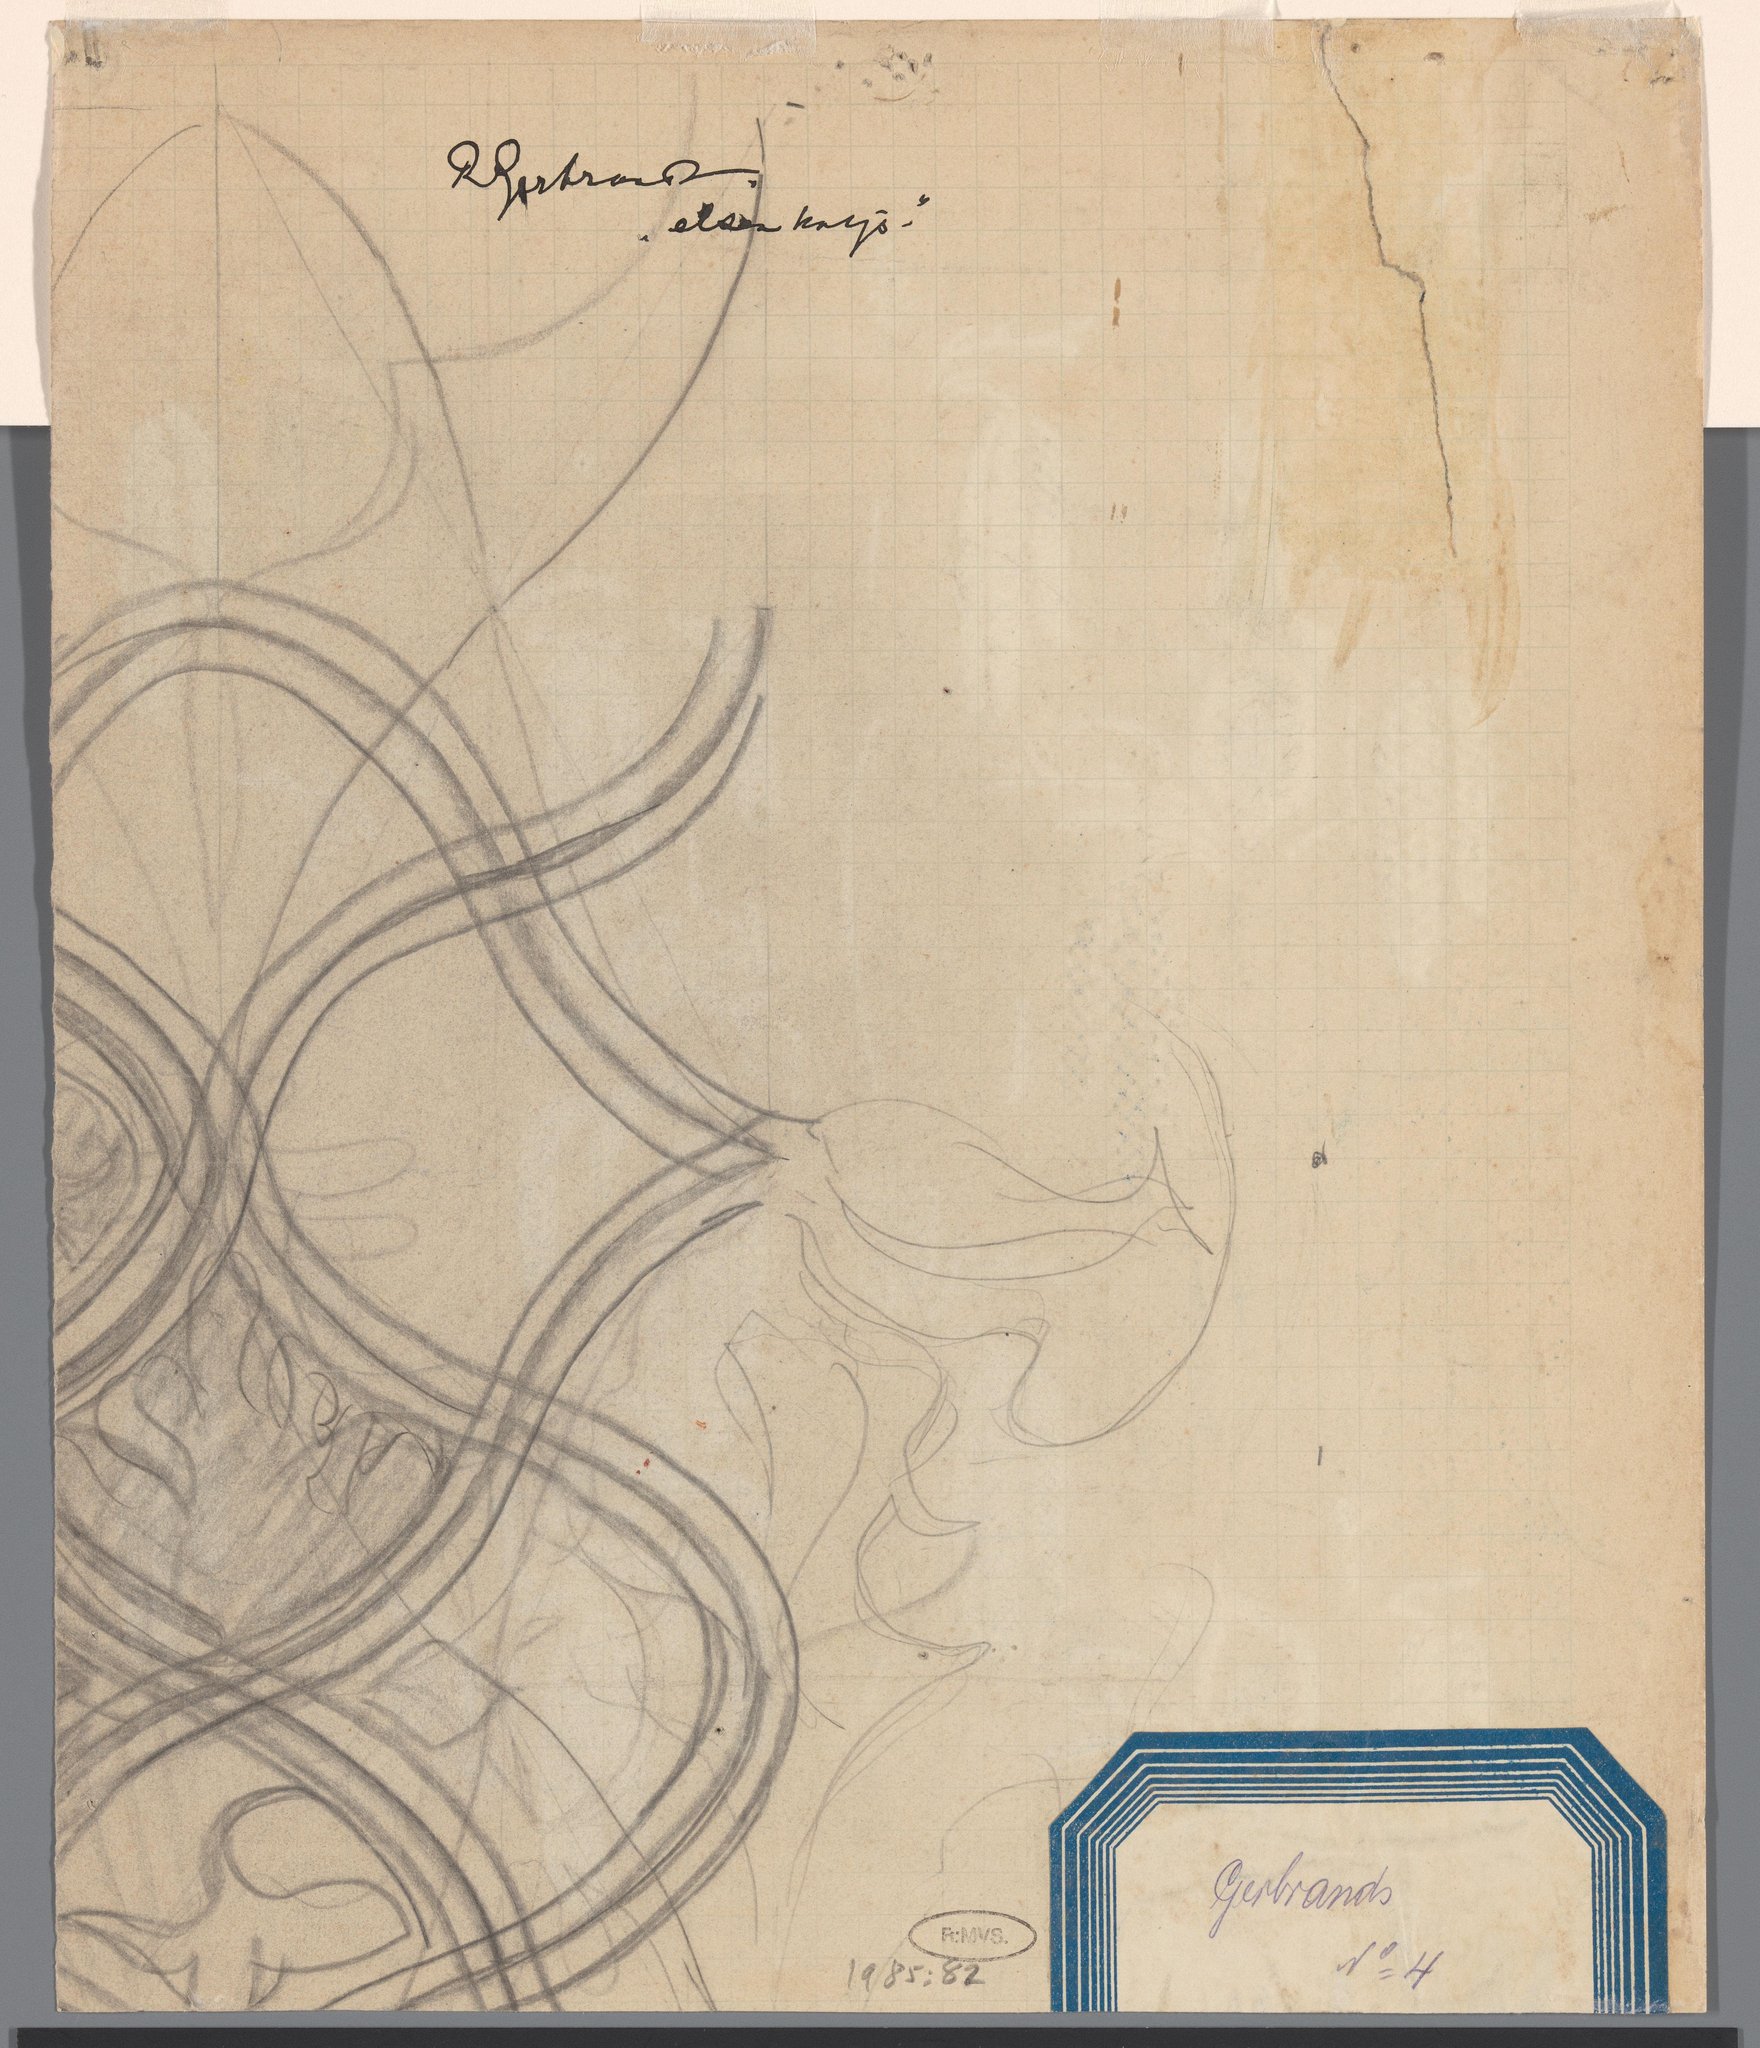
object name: drawing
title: Decorative Designs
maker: roelf gerbrands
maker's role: designer, draughtsman, print maker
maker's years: 1891-1954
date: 1921-1954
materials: pencil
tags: ornament derived from plant forms - aa - stylized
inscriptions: : ‘Gerbrands No = 4’, collector's mark: Lugt 2228